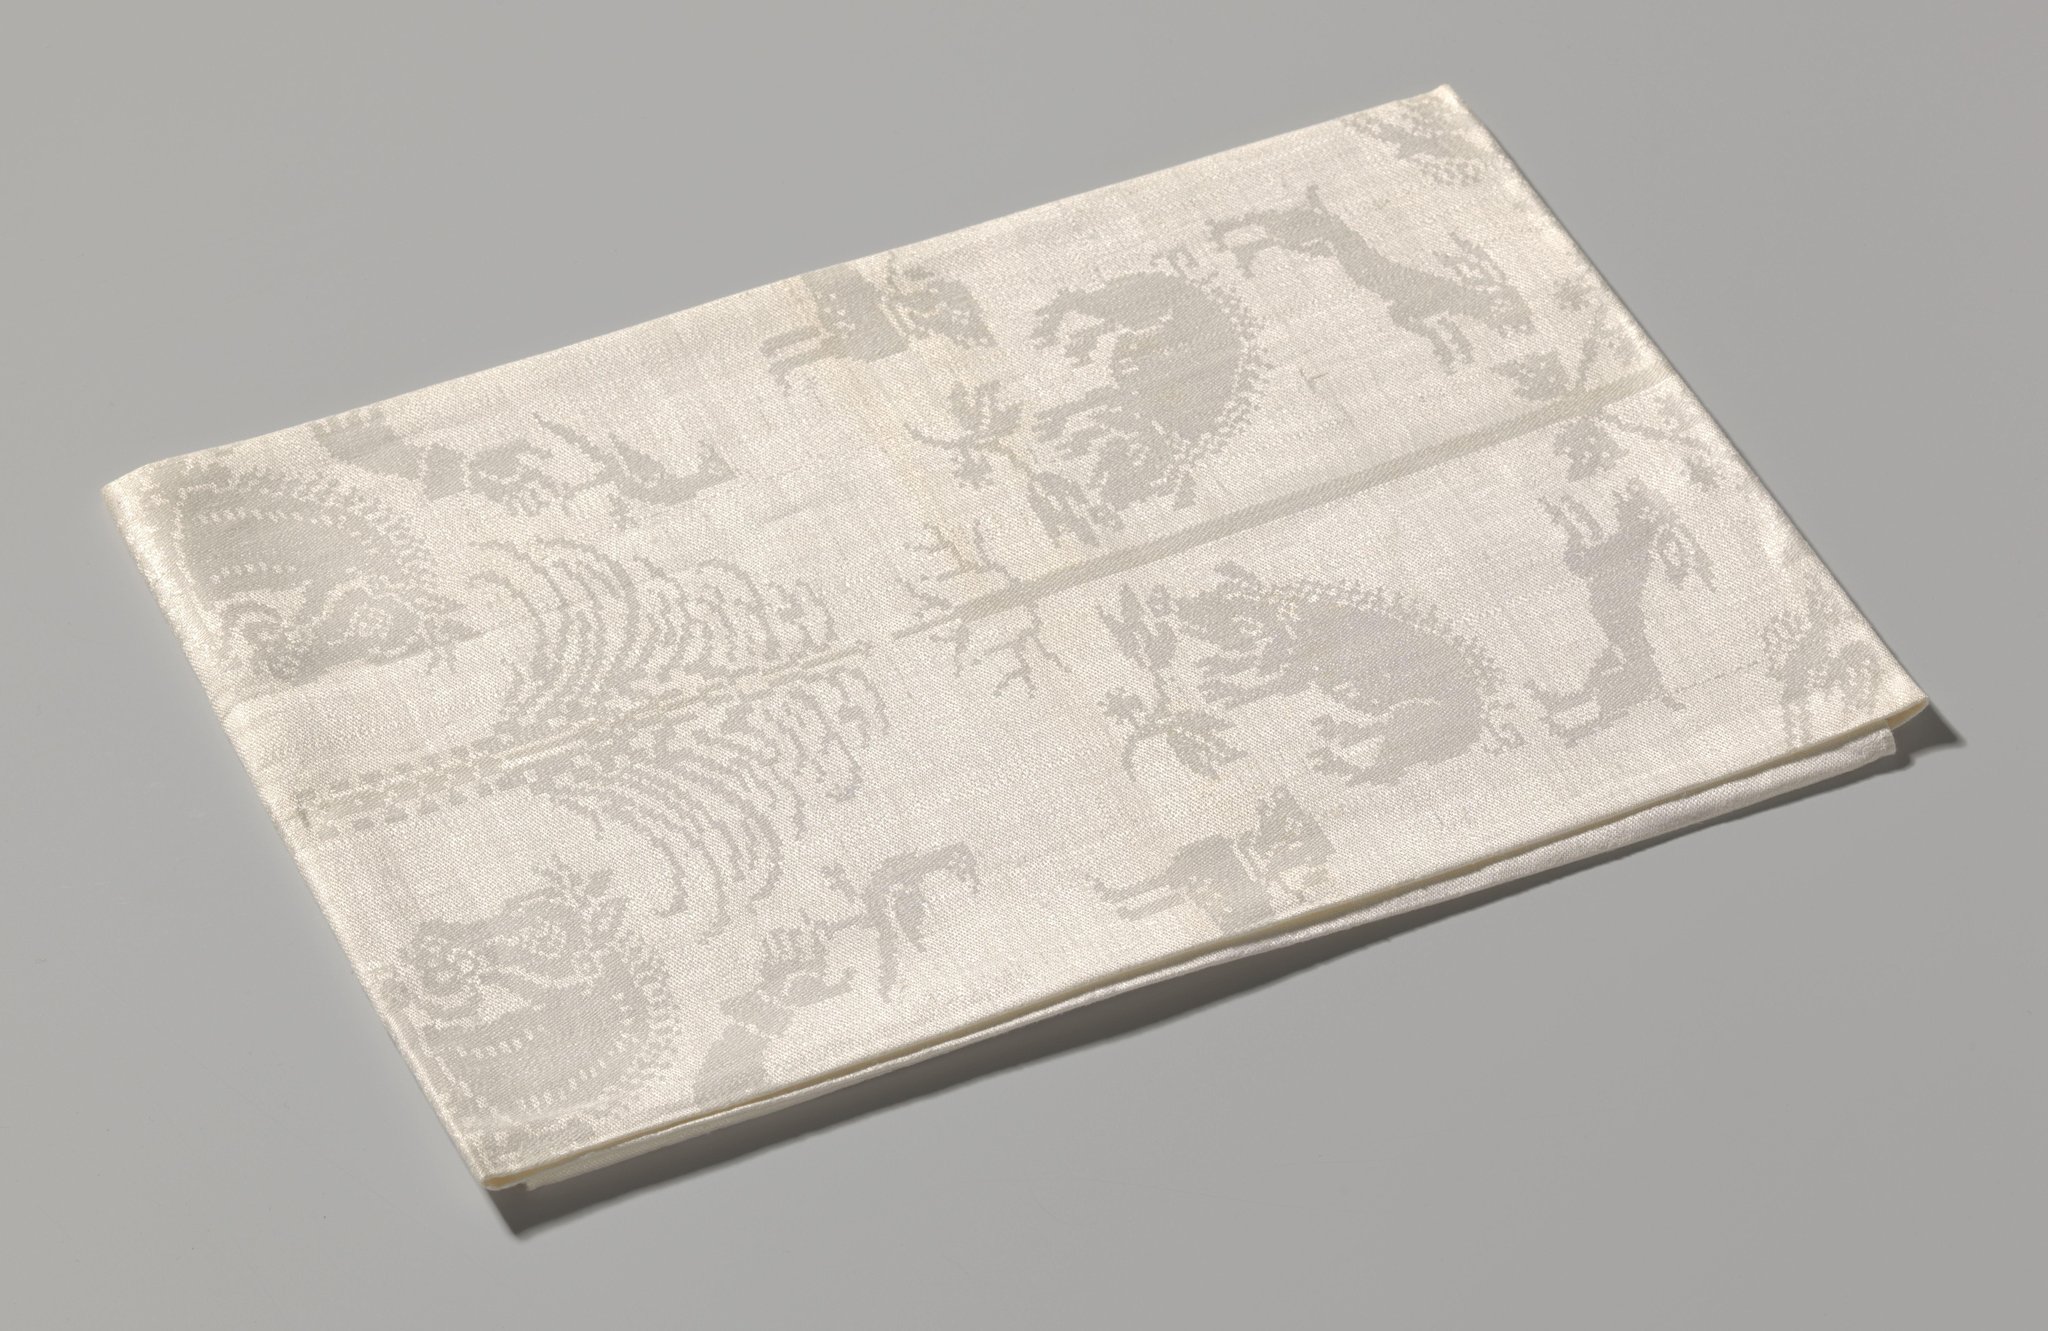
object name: napkin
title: Servet van linnendamast met een jachttafereel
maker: Anonymous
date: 1625-1650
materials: linen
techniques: damask, weave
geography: flanders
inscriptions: number: ‘28’, mark: ‘"BR" met daarboven een kroon’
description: Wit linnendamasten servet met jacht te paard, met centraal fontein en huizen. Onderaan een levensboom. Gemerkt met roodbruine kruissteek "BR", een kroon en "28" in schuin tegenoverliggende hoeken.